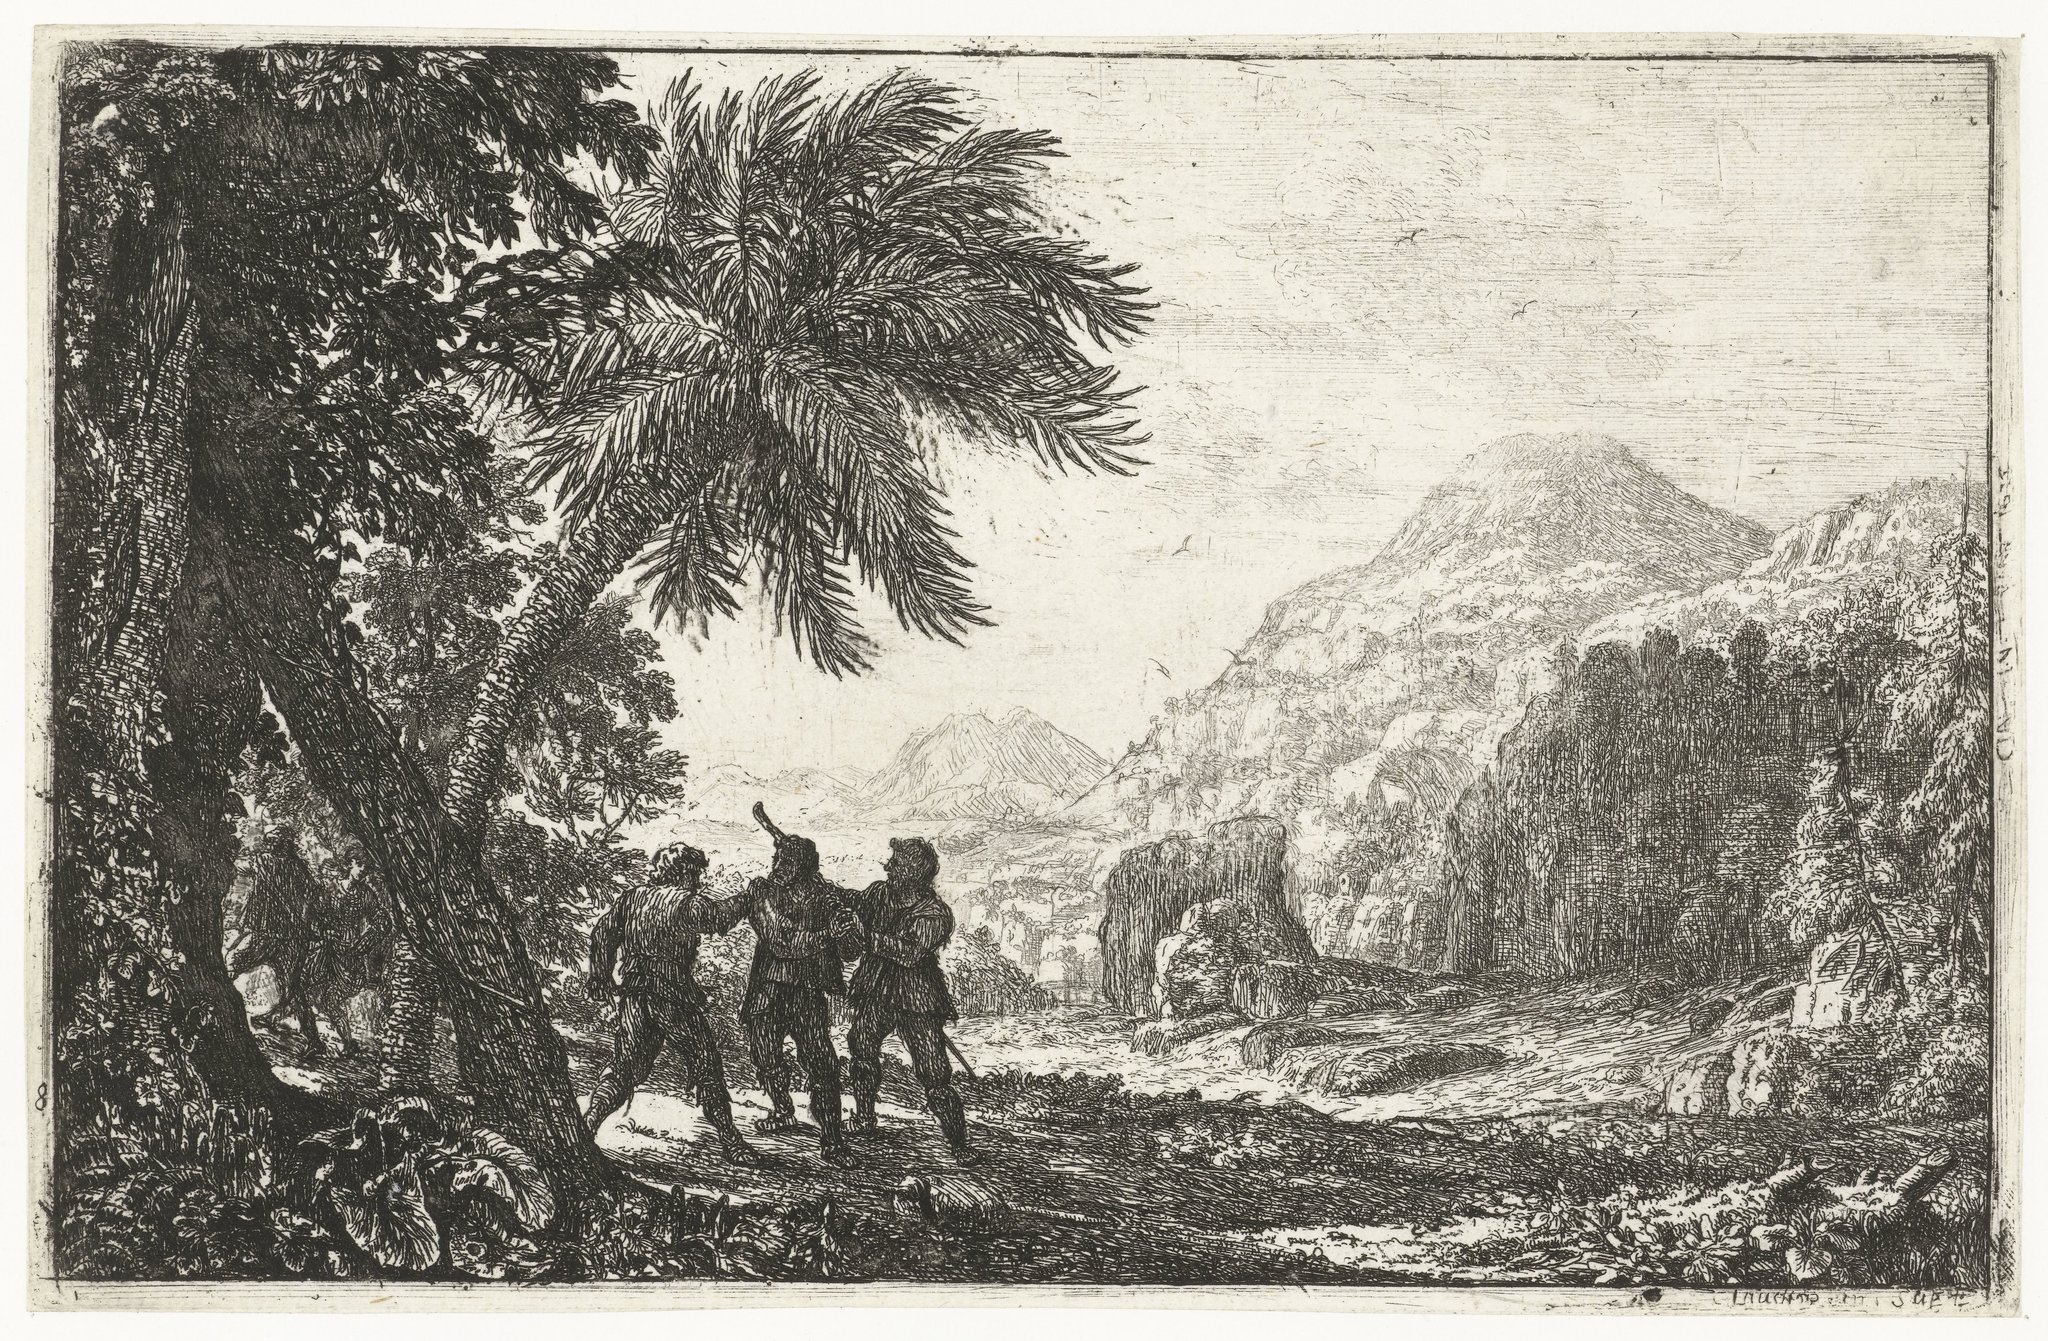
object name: print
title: Scène de brigands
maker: claude lorrain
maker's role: draughtsman, print maker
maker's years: 1604-1682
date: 1633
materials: paper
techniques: etching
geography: rome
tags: traveller(s) attacked by robber(s), robbery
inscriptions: collector's mark: Lugt 240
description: Twee struikrovers overvallen een man bij een bosrand, in een bergachtig landschap.